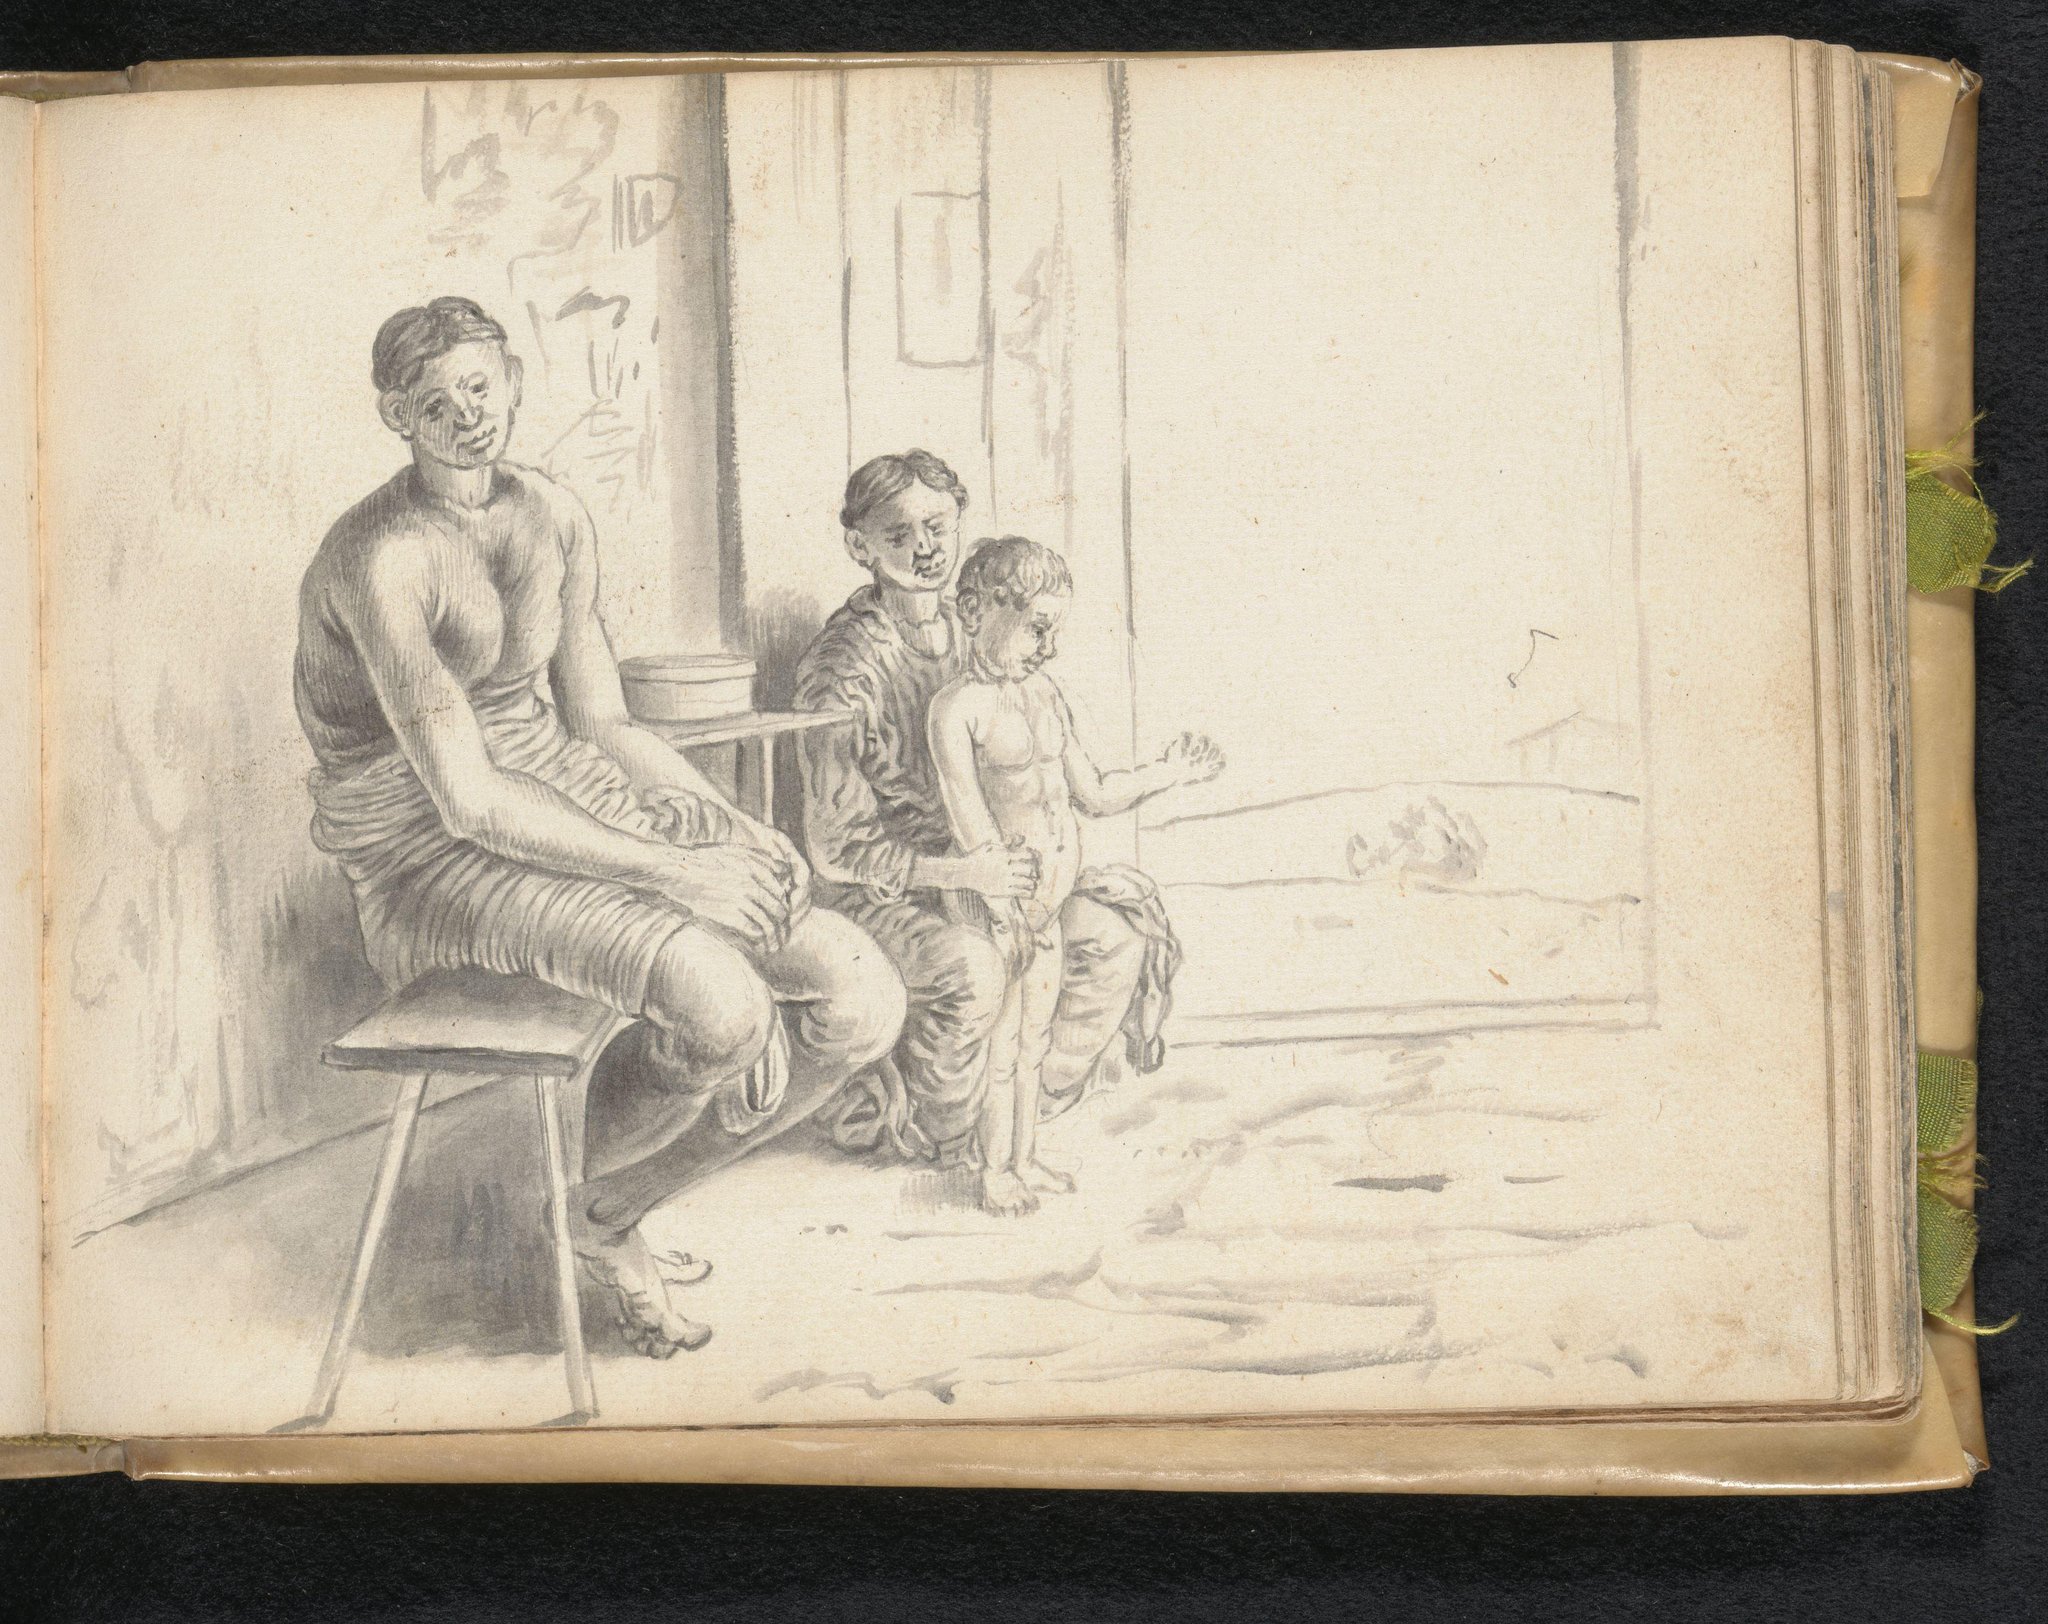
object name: sketchbook leaf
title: Man, woman and little boy, inside the house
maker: esaias boursse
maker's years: 1631-1672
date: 1662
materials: ink, paper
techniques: brush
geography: sri lanka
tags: asiatic races and peoples (with name), 41d232(...) skirt (lungi), eurasion, half-caste, skirt (with name), clothing for the upper part of the body (with name), styles of hairdress (with name) - ~women, interior of the house, sri lanka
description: Binnen in huis zijn een man, en vrouw en een kind getekend, naast een open deur met uitzicht naar buiten. Het kan een Euraziatisch of Singalees gezin zijn. Links zit de man op een houten bank met zijn rug naar de muur. Hij is gekleed in een opgeschort heupkleed (veshti, lungi). Zijn haar is met een scheiding in midden naar achter gekamd. Er is geen baardgroei te zien. De vrouw zit vlak bij de deur op een niet zichtbaar krukje. Ze draagt een wikkelrok (redda) en een Portugese bloes met V-hals en lange mouwen (hatte). Het haar met scheiding in het midden is naar achter gekamd en vastgestoken in een wrong (condé). Tussen haar knieën staat een bloot jongetje, wiens onderarm ze met haar rechterhand vast houdt. Tegen de zijwand – tussen de figuren – staat een rek waarop een ronde doos met deksel. De vloer lijkt van aangestampt leem (mati). In de openstaande deur is schetsmatig een gesloten luikje aangegeven. Blad 79 uit een schetsboek met 117 bladen.